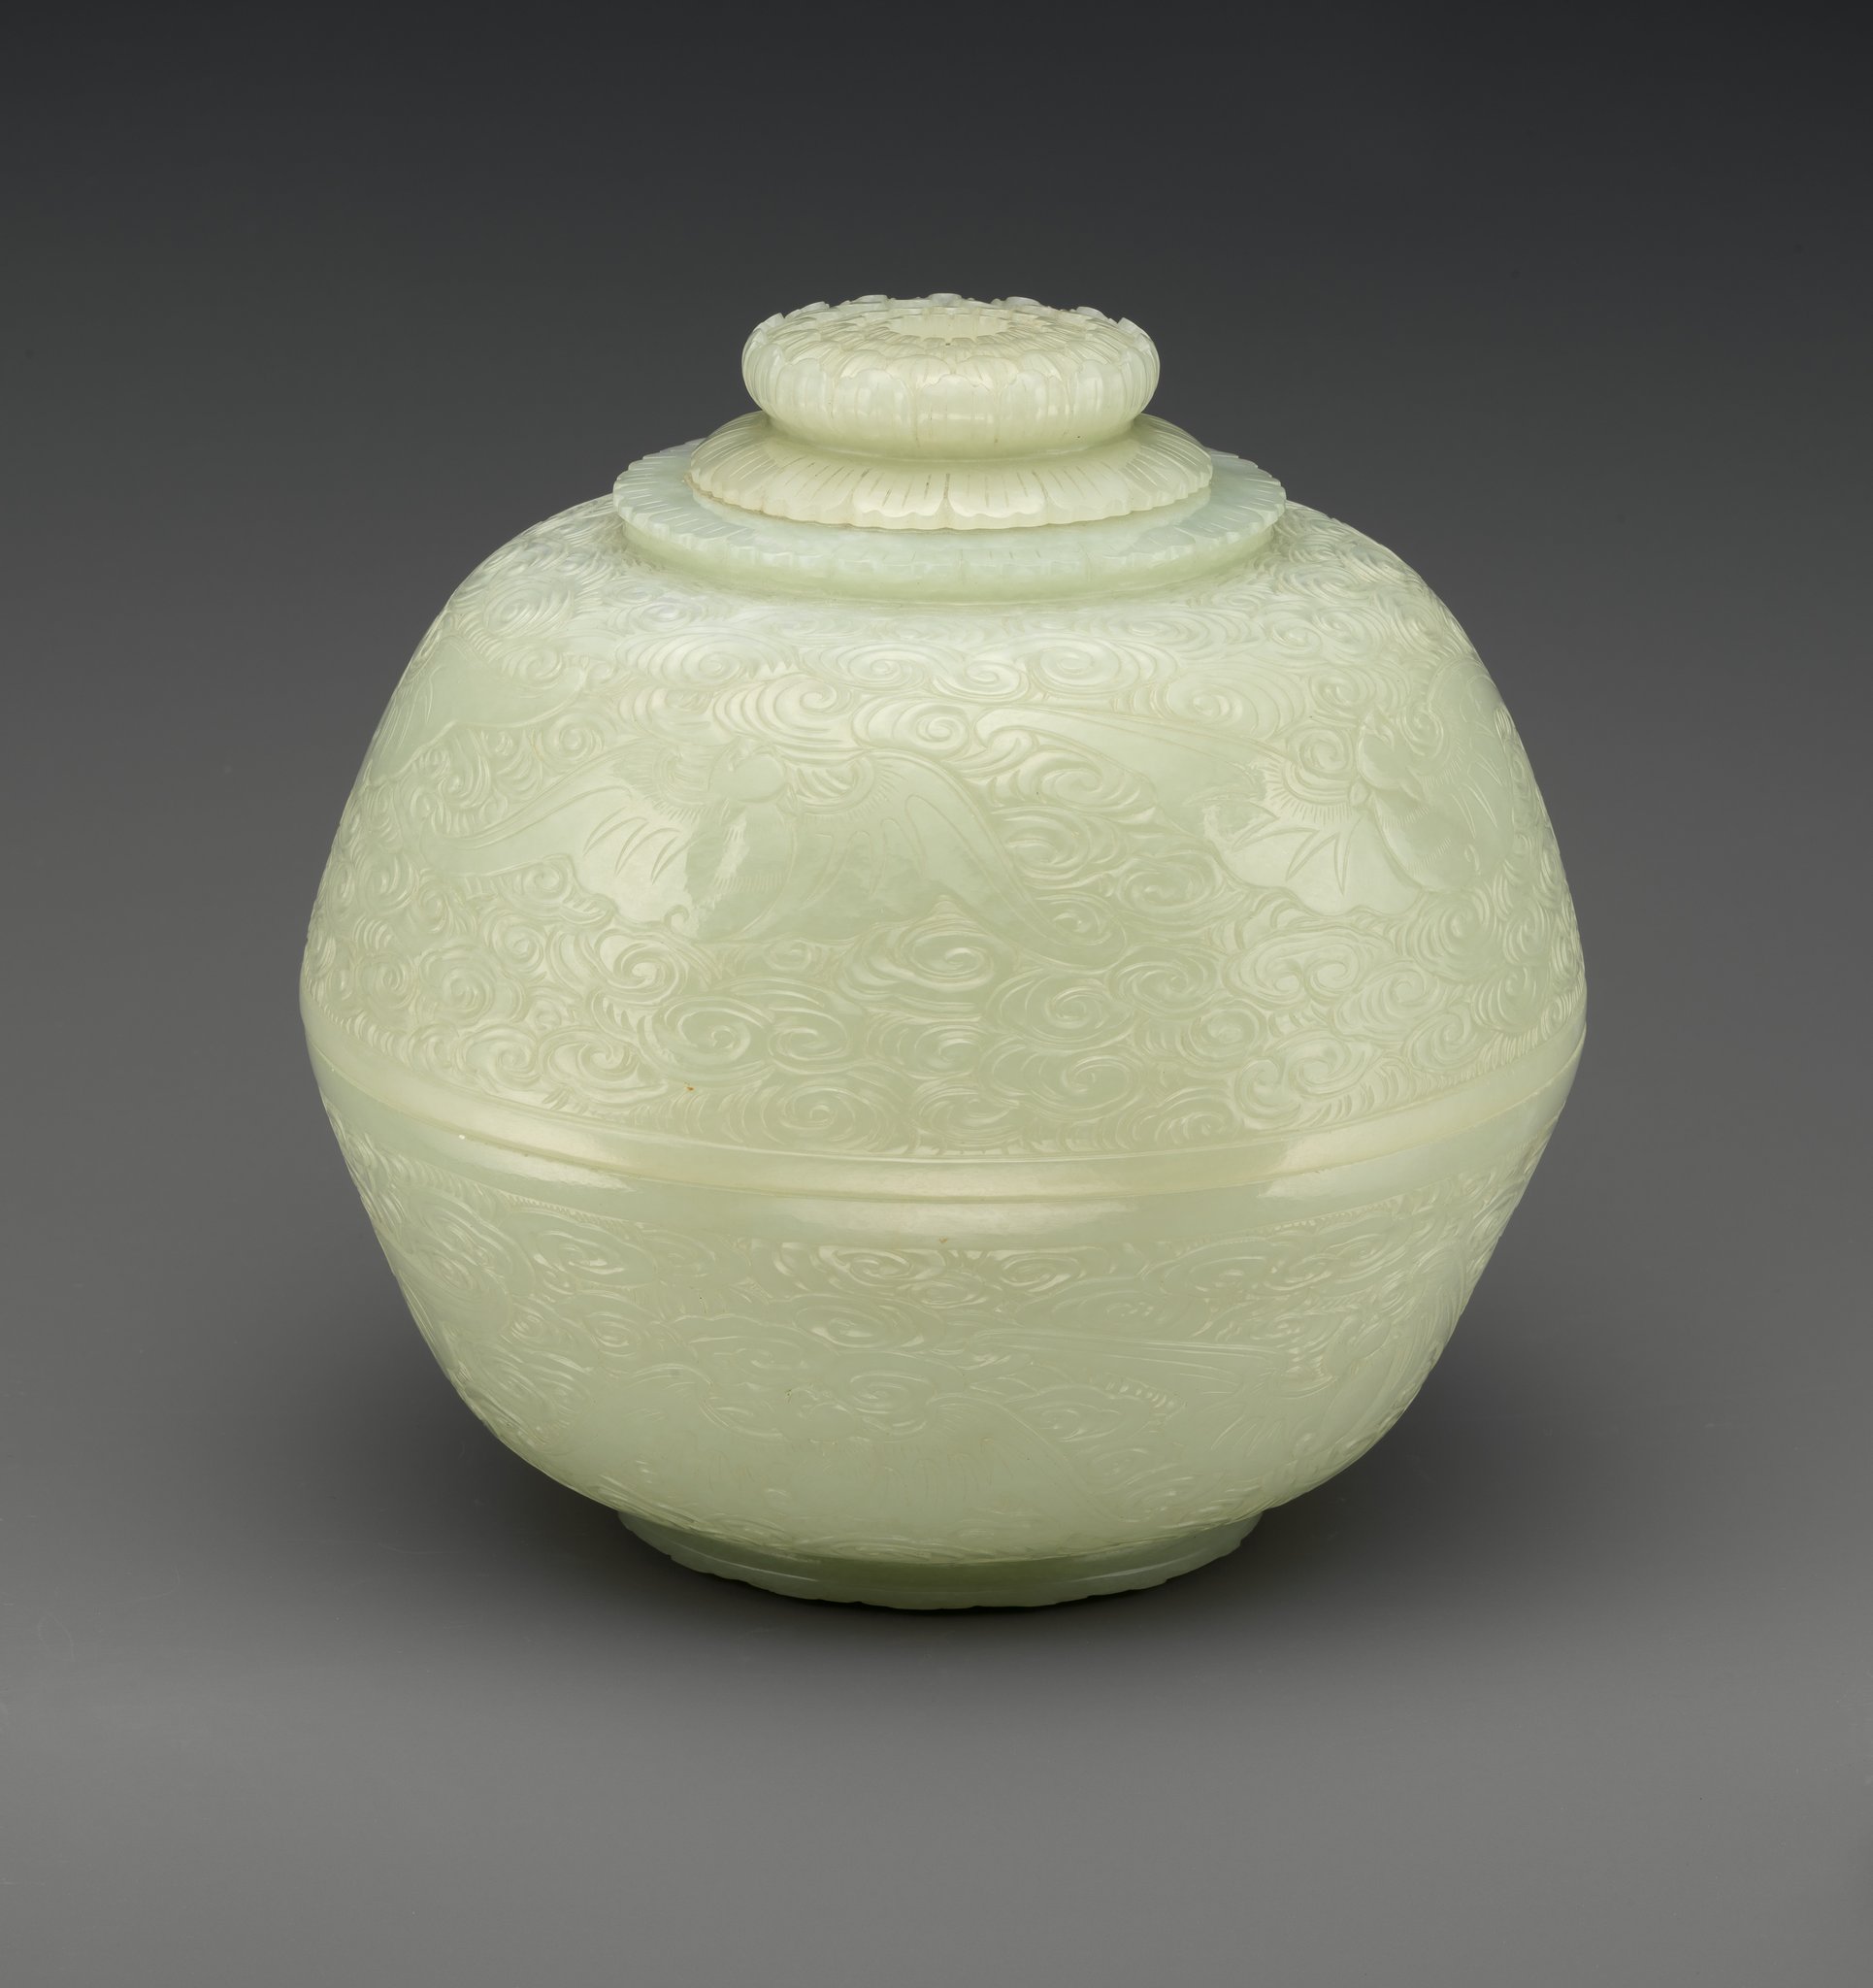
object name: bowl with cover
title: Bowl and cover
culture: chinese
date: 1736-1795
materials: jade